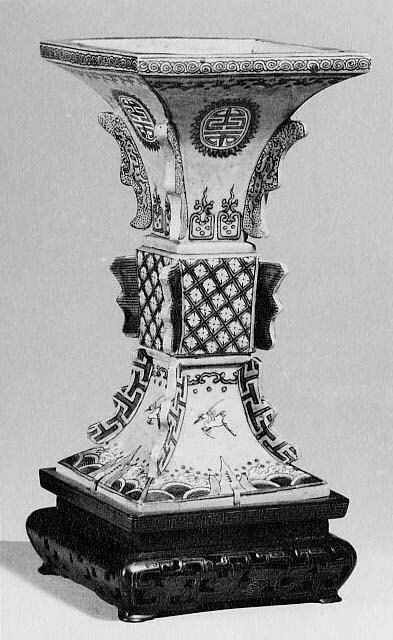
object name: vase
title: Vase (one of a pair)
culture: chinese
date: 1667-1733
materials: biscuit, enamel, porcelain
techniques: painting